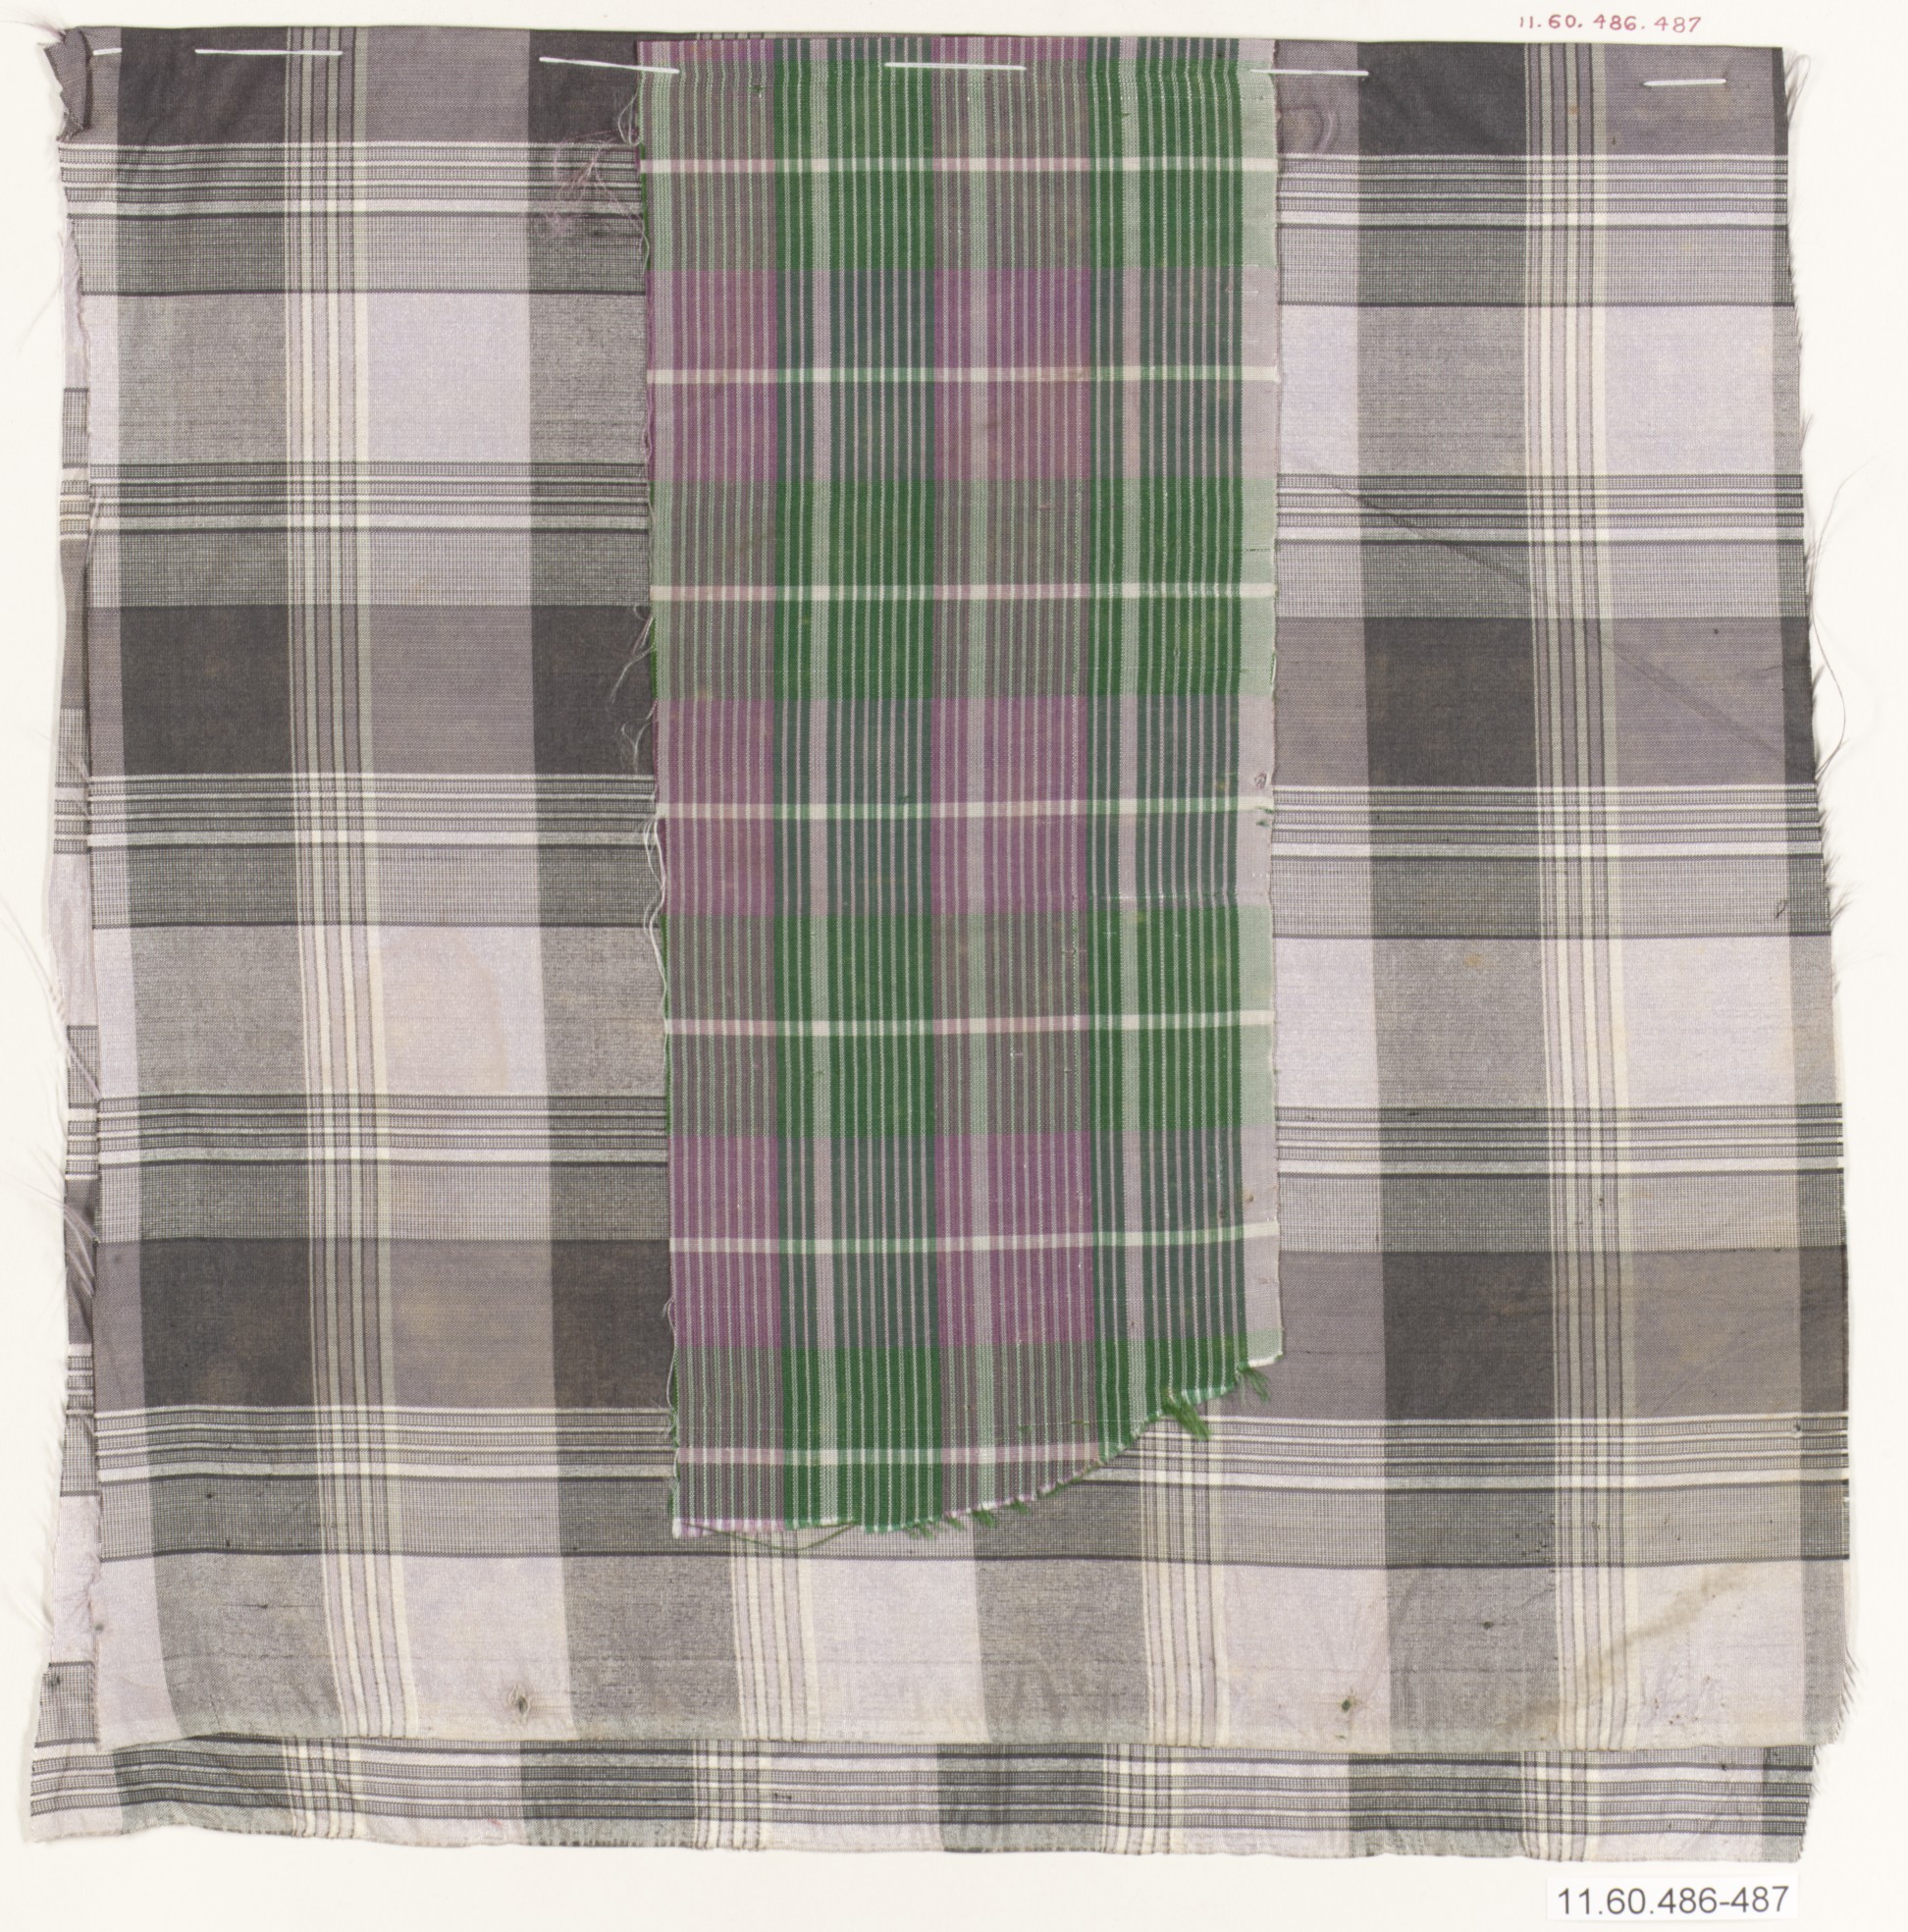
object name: sample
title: Samples (2)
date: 1834-1866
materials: silk